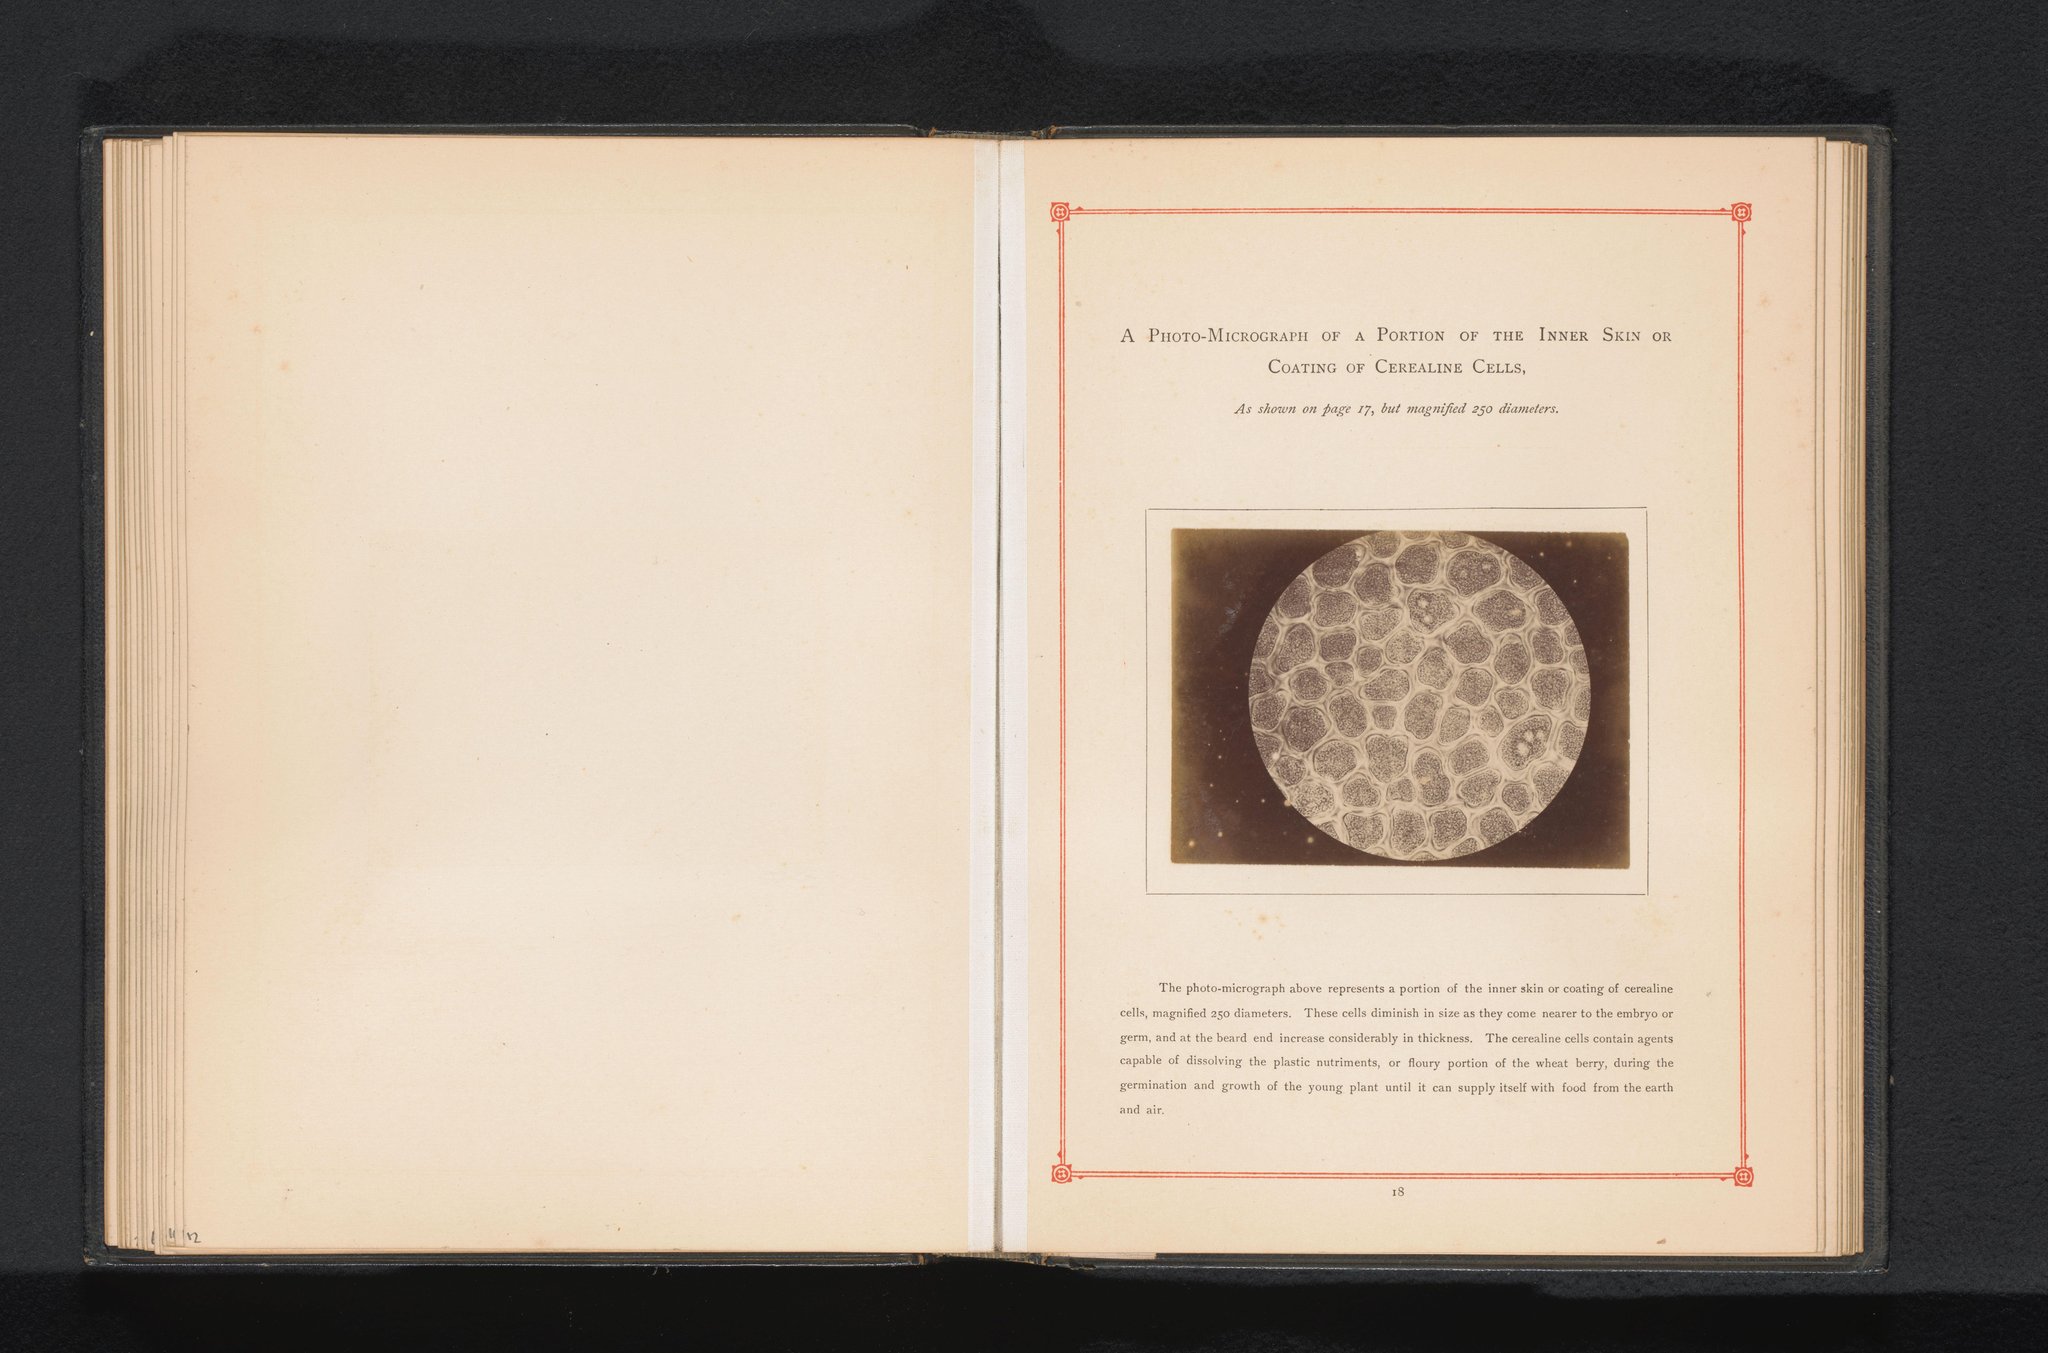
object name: page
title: A photo-micrograph of a portion of the inner skin or coating of cerealine cells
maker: robert w. dunham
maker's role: fotograaf, wetenschapper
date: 1882-1892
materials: photographic support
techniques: albumen print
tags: plants and herbs: wheat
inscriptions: inscription: ‘As shown an page 17, but magnified 250 diameters.’